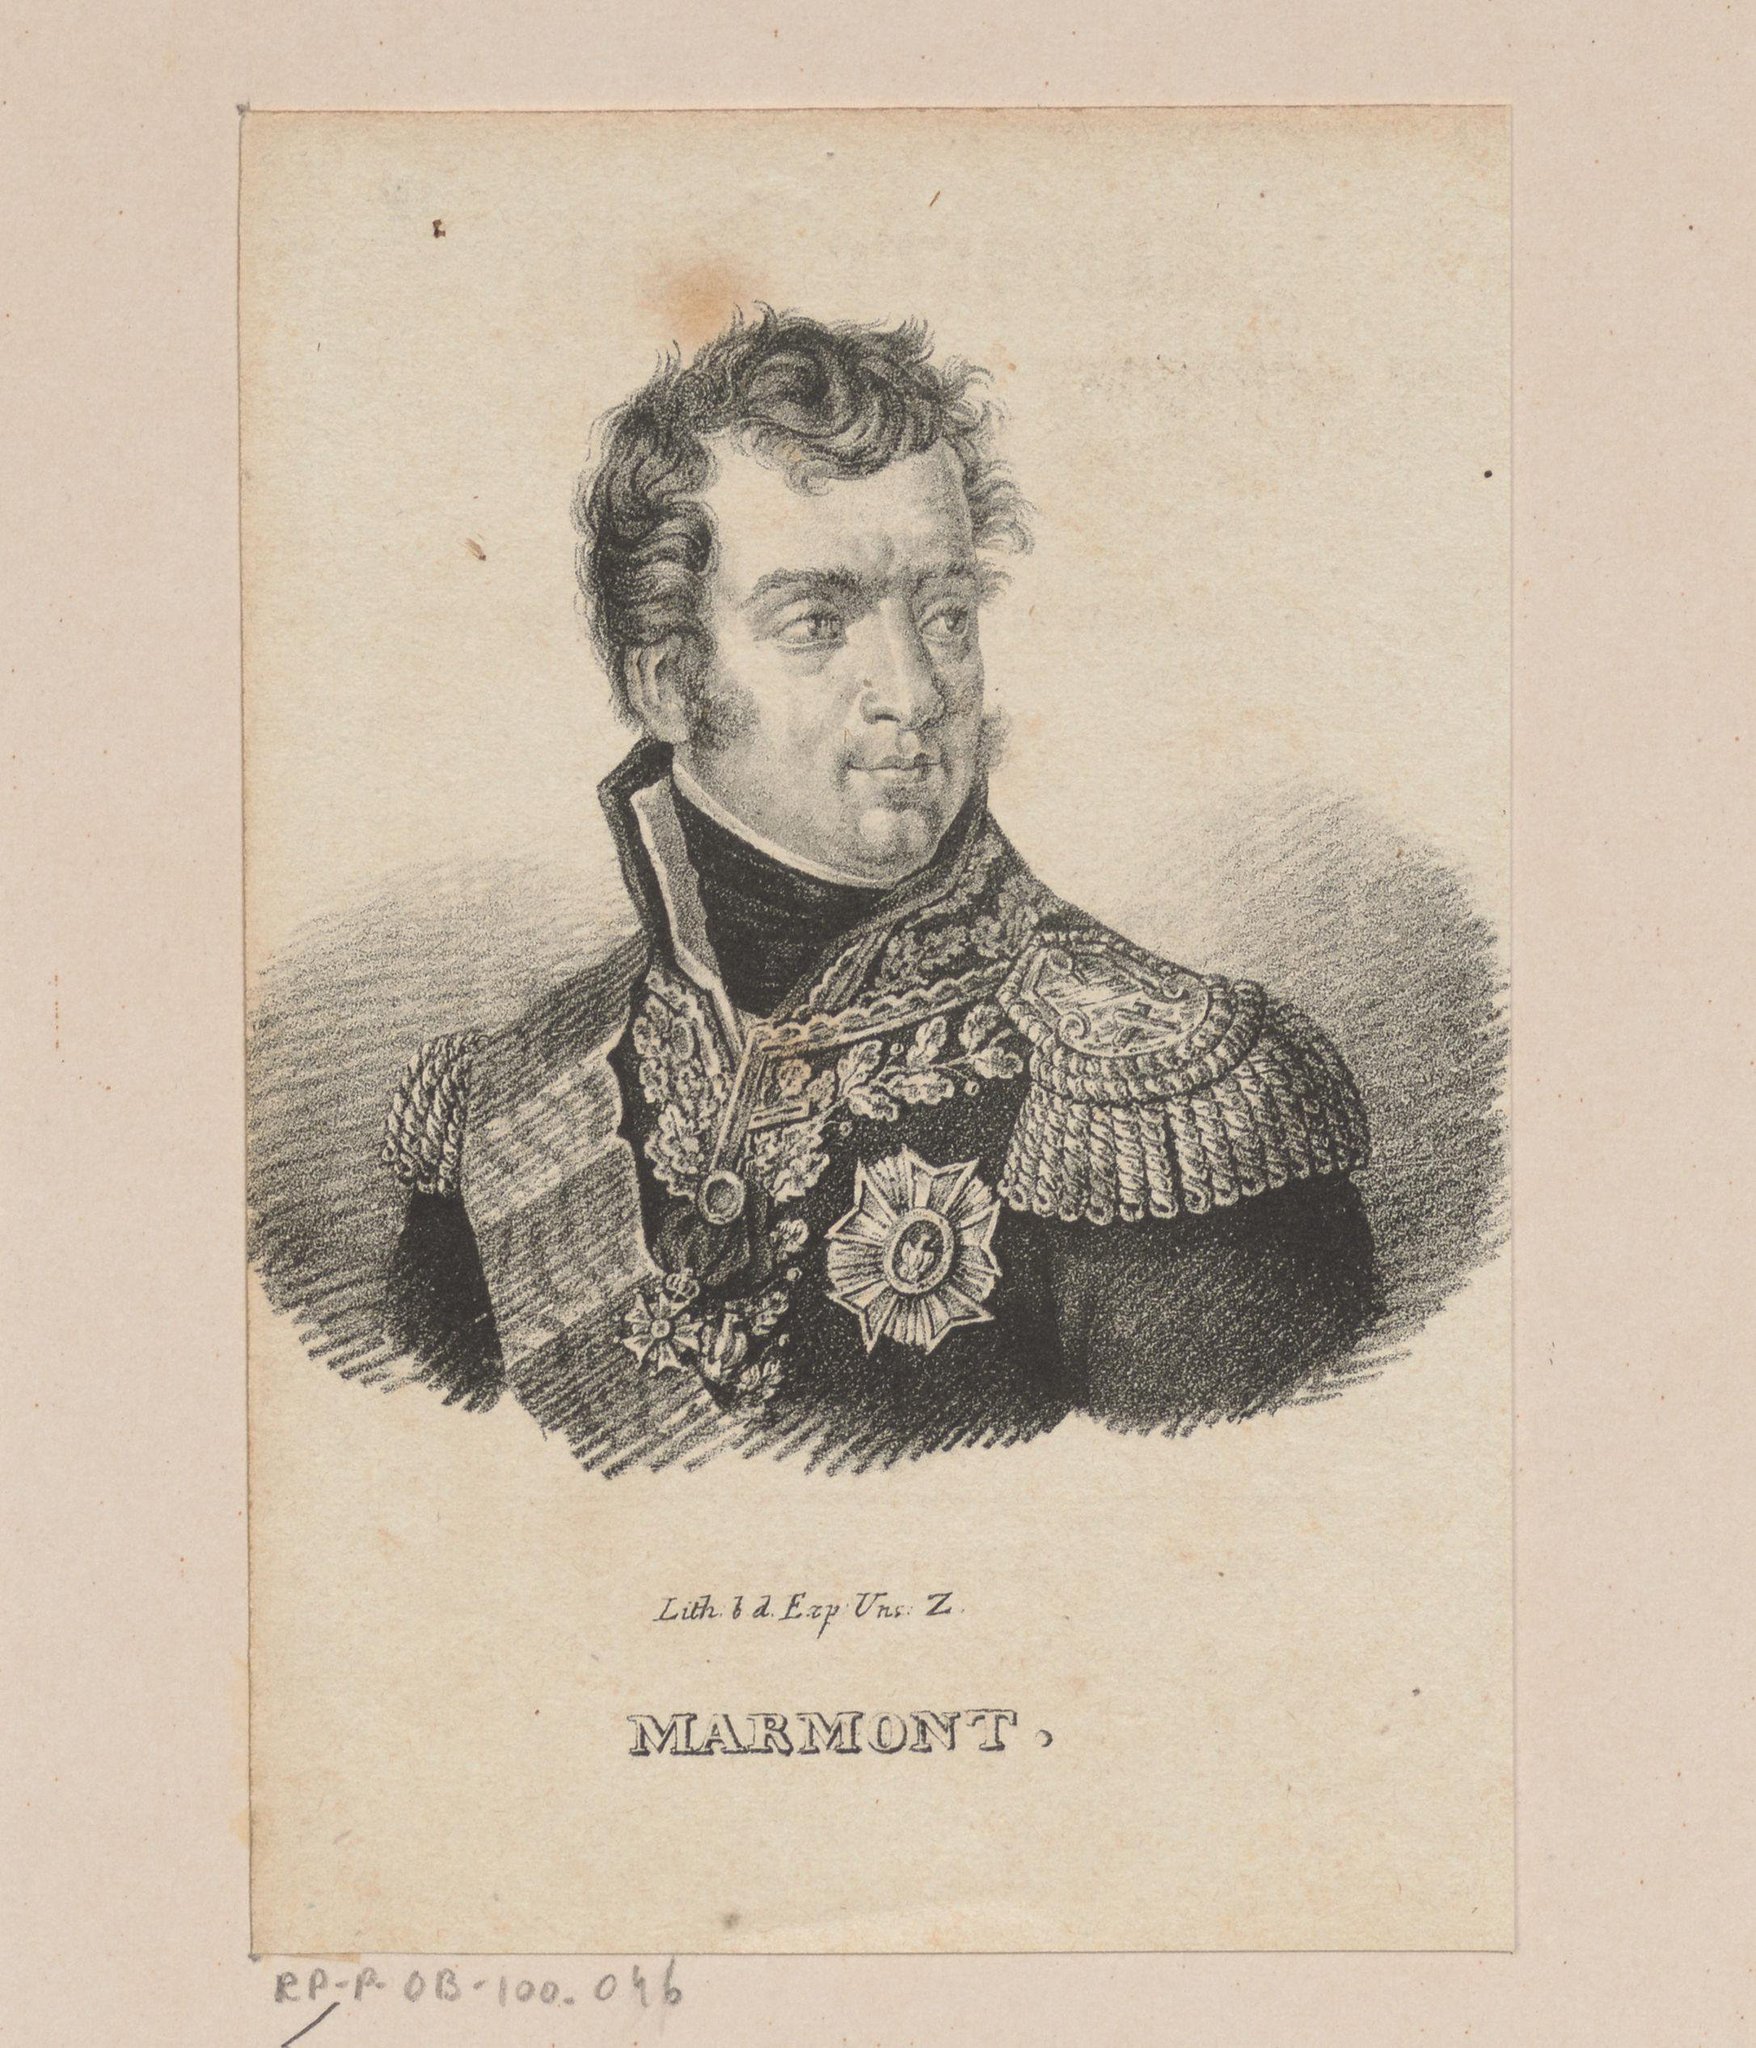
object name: print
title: Portret van Auguste de Marmont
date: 1805-1850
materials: paper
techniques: lithograph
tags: historical persons, (military) uniforms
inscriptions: signature: ‘Lith. b. d. Erp: Uns: Z.’